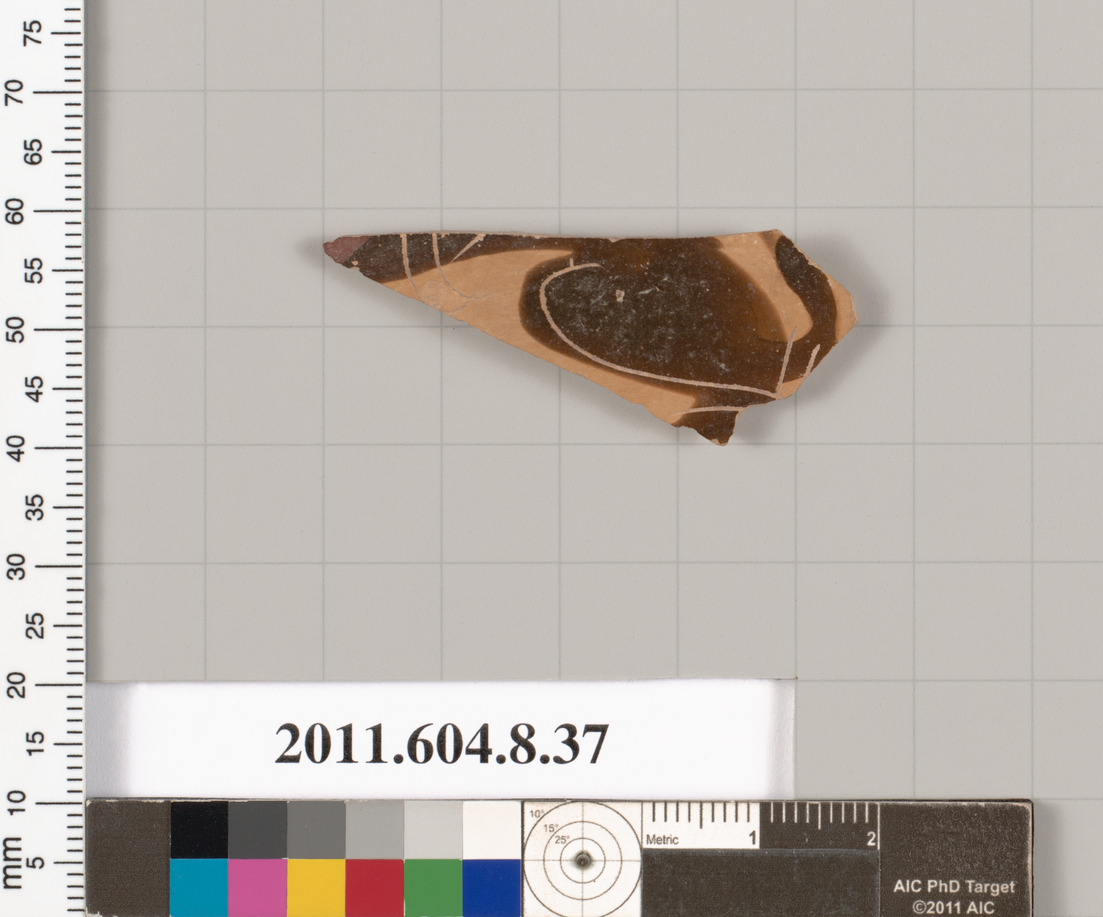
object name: undetermined open shape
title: Terracotta fragment of an open shape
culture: greek, corinthian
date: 600-501 BCE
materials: terracotta